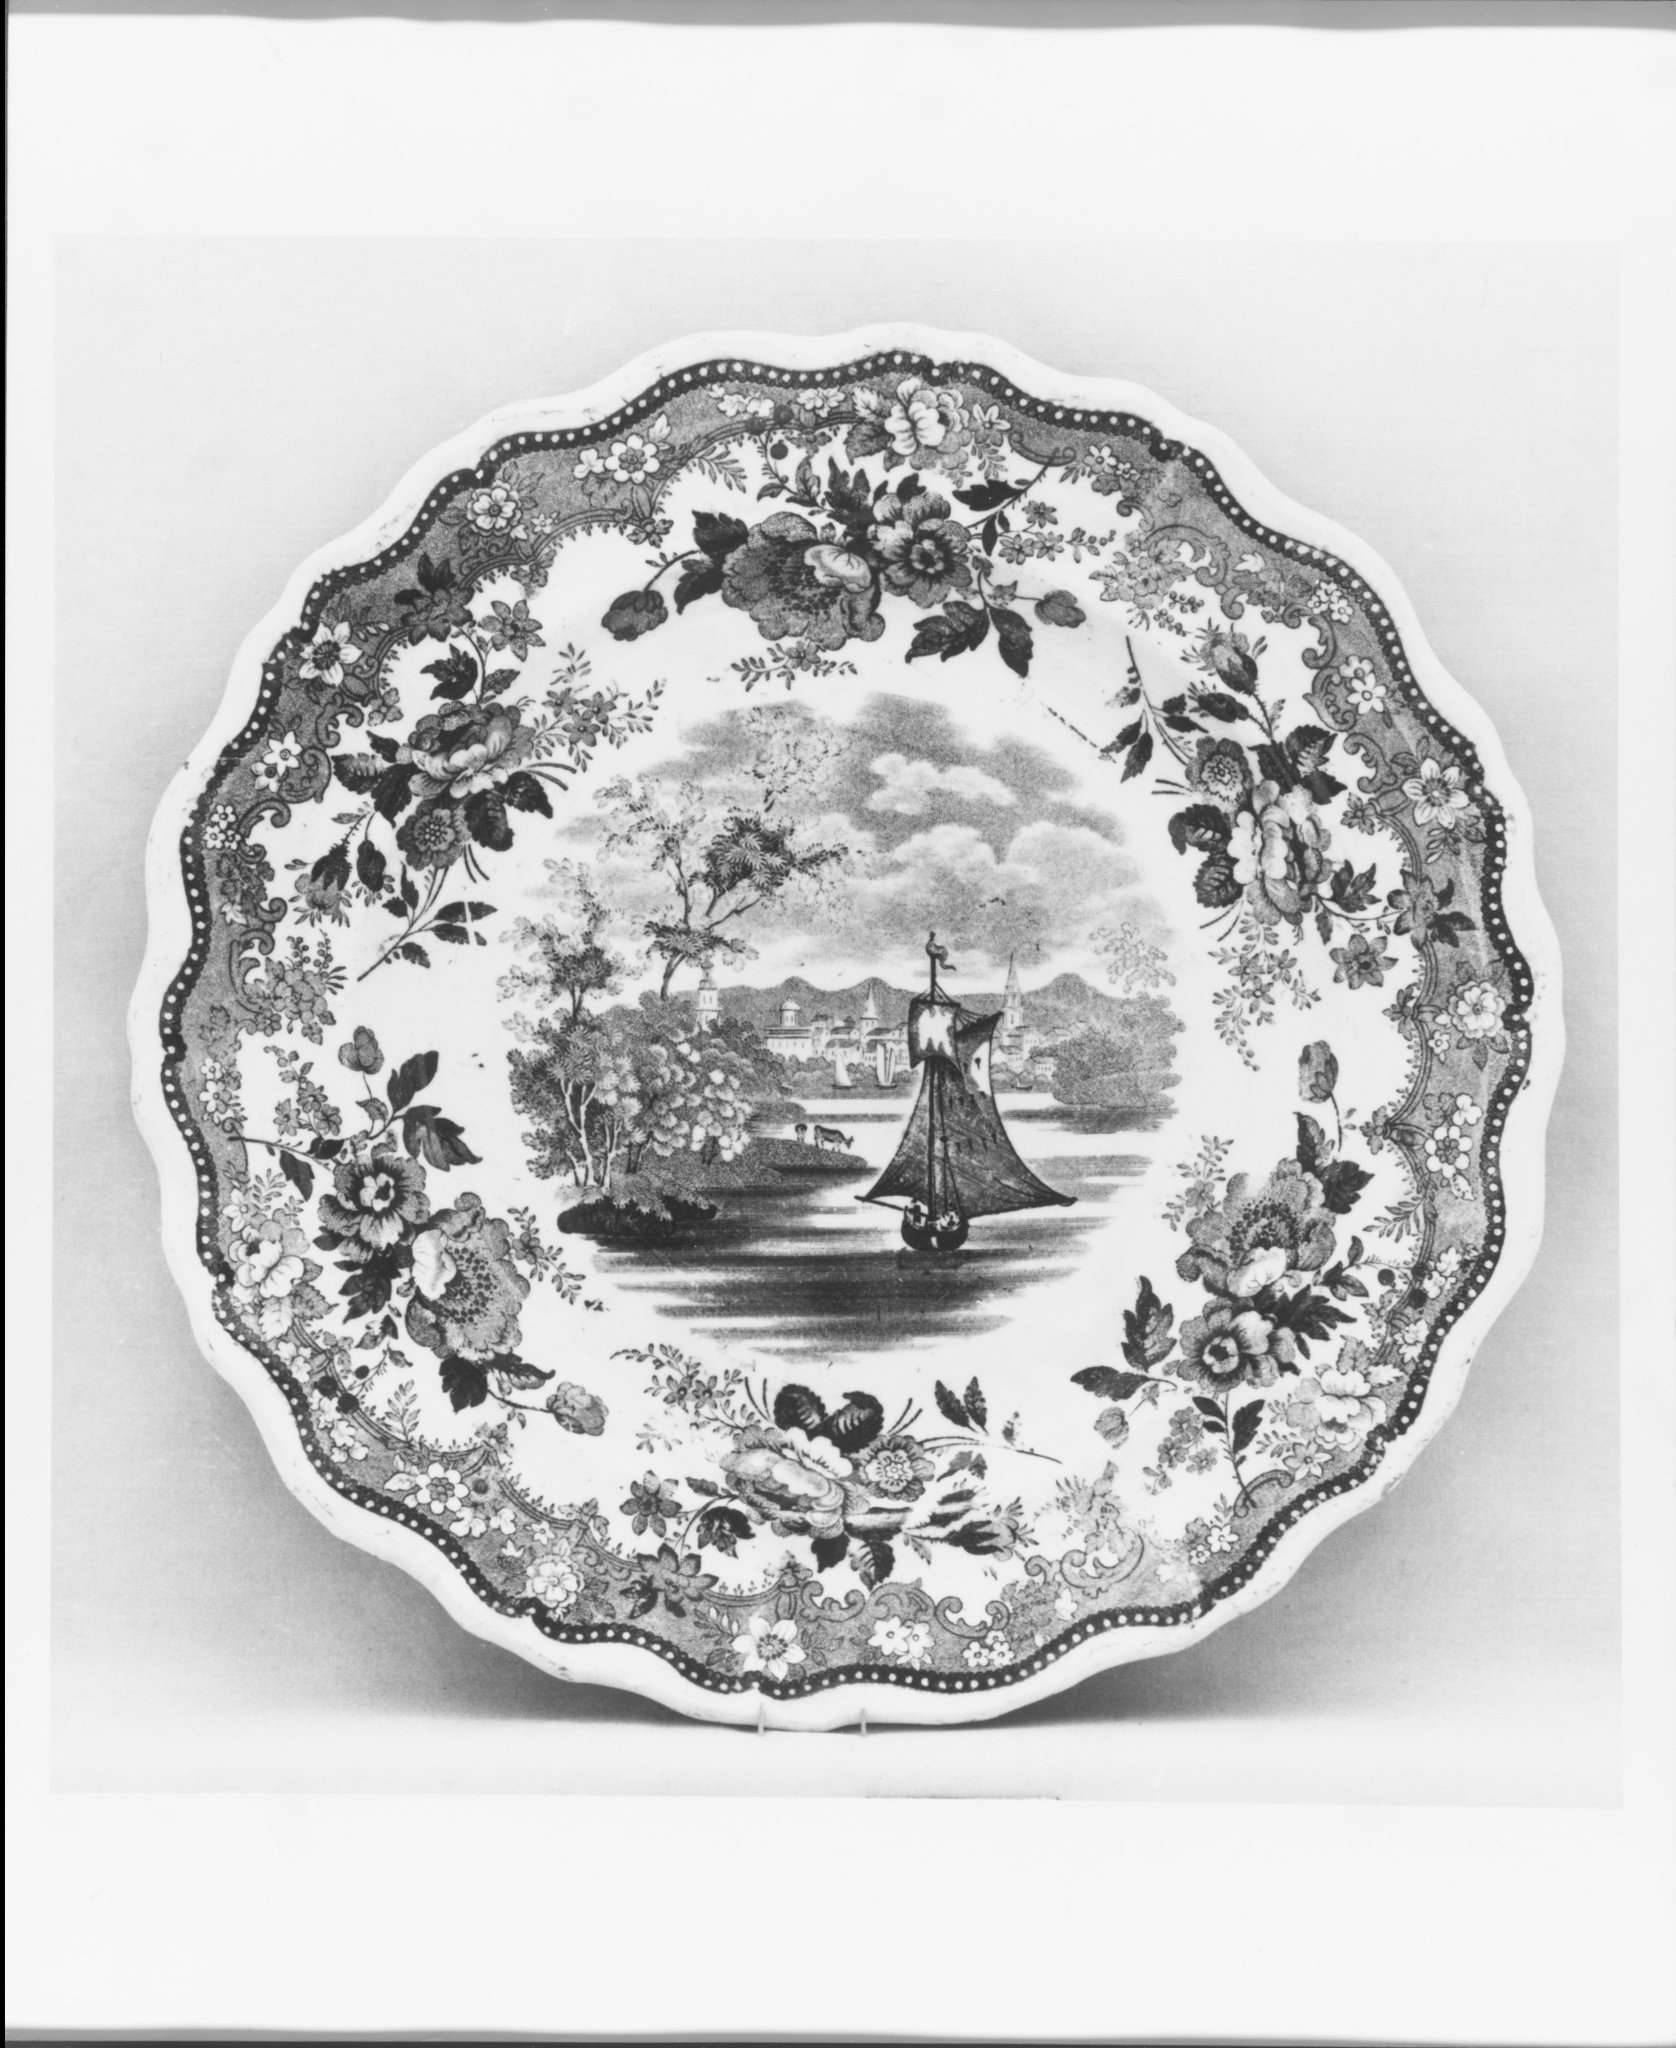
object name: plate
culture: british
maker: job & john jackson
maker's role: maker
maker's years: 1831-1835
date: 1831-1835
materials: earthenware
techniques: transfer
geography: england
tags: landscapes,boats